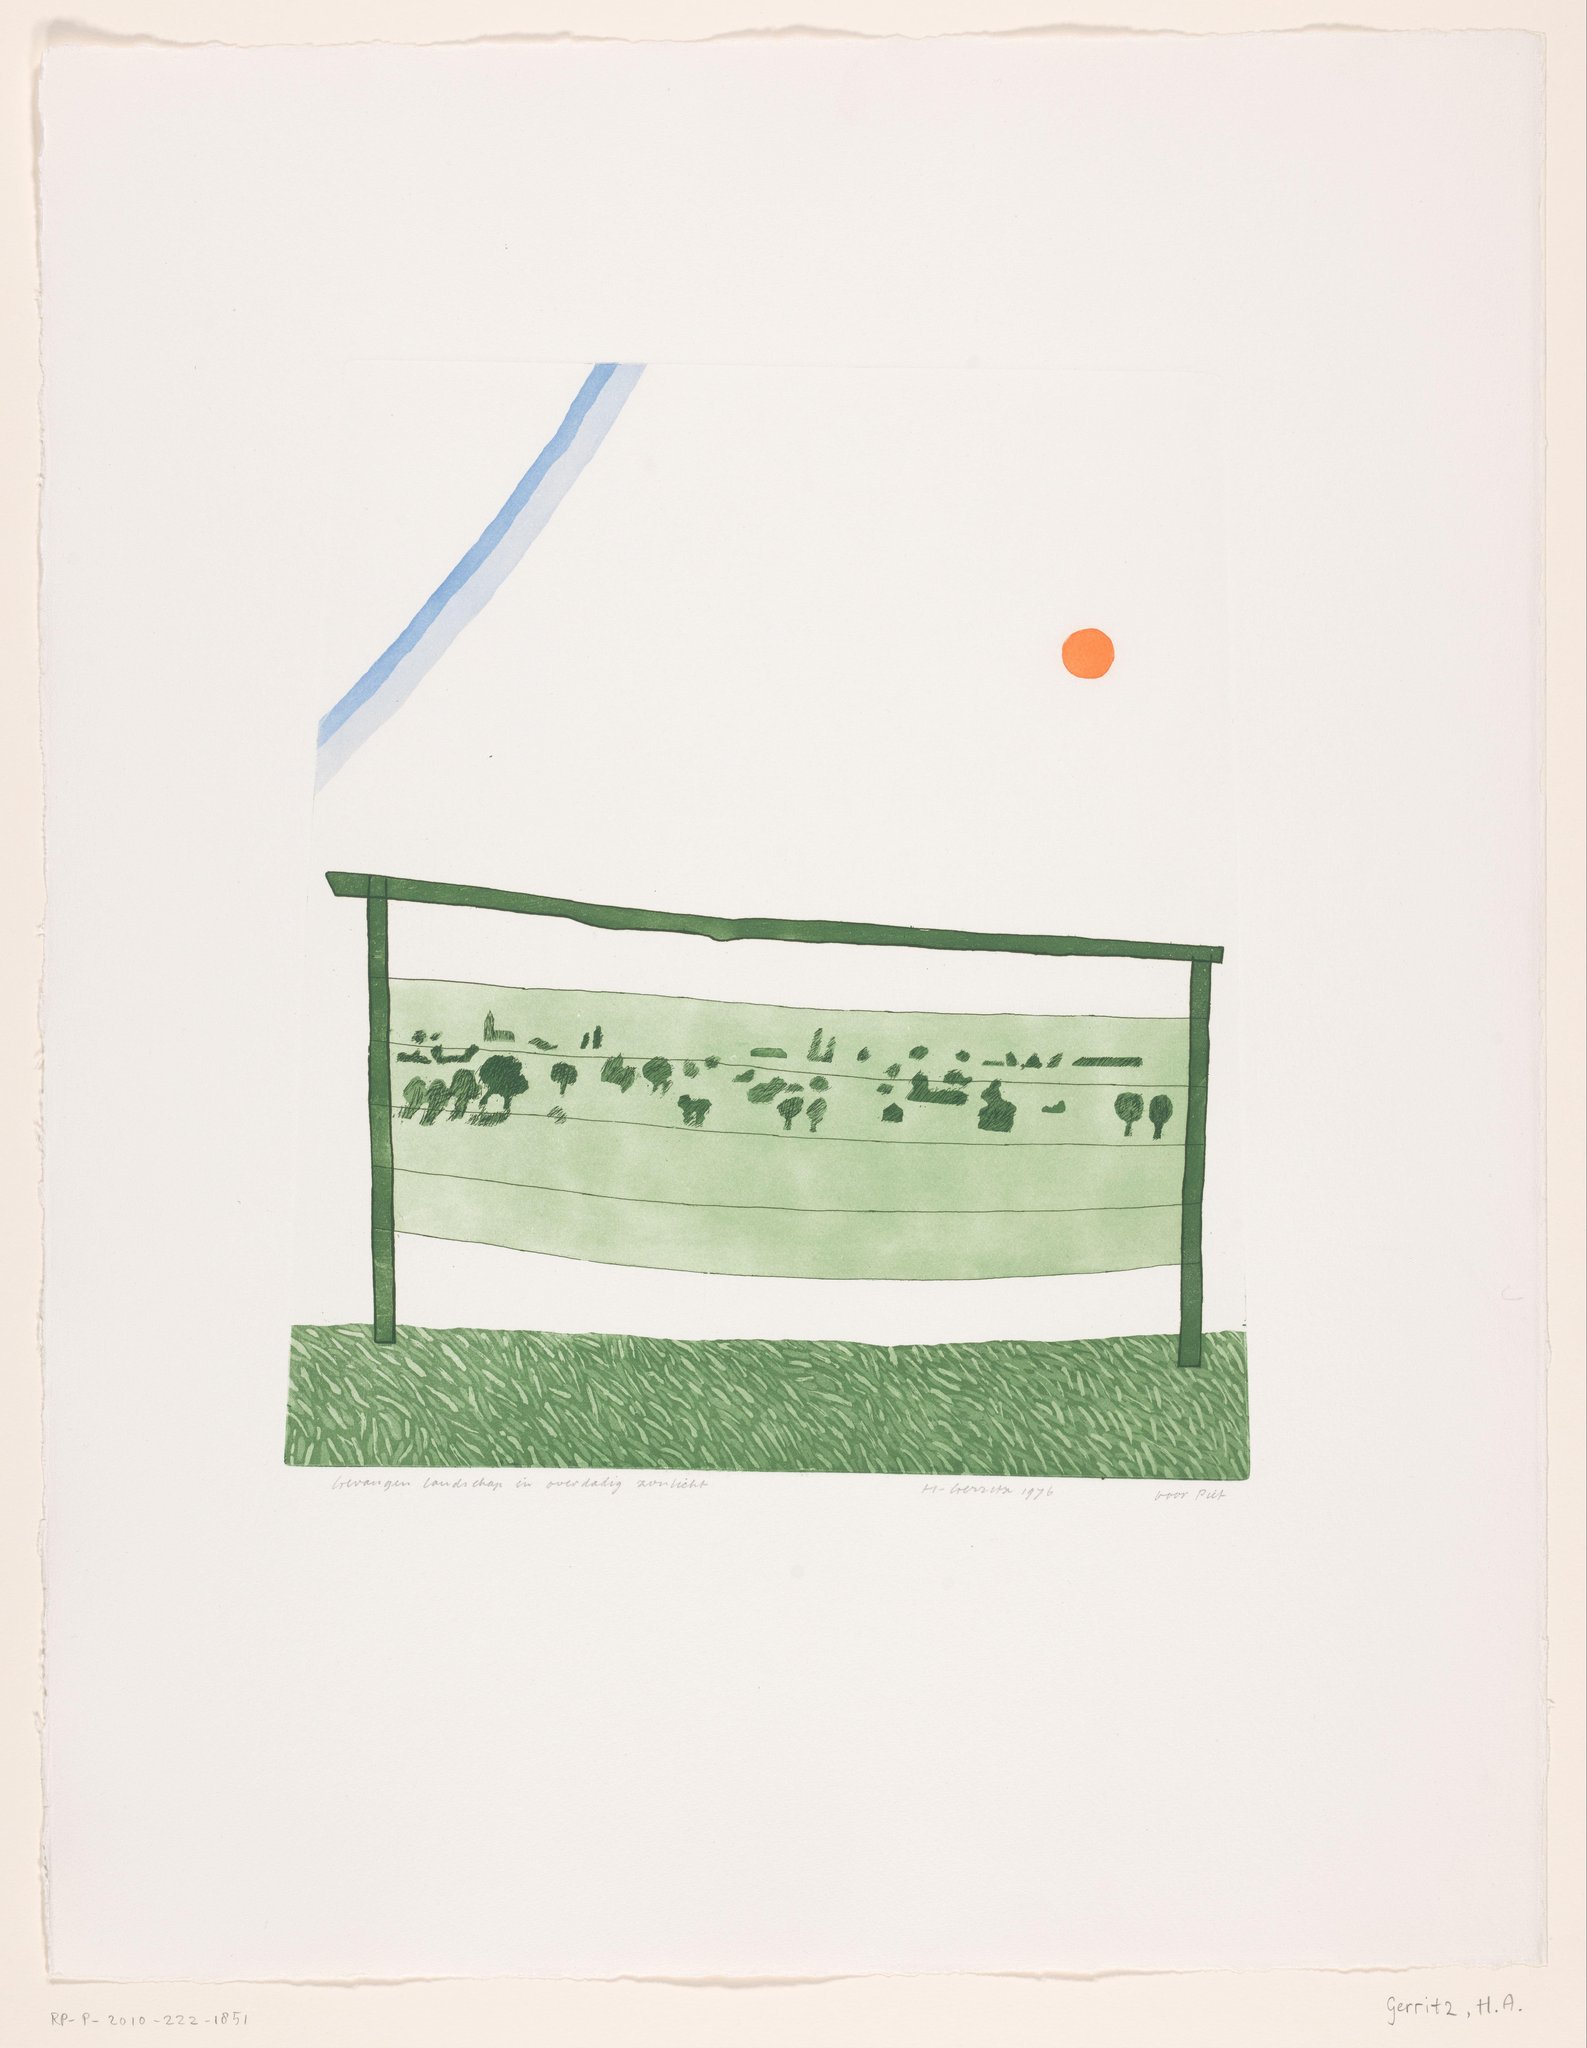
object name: print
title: Gevangen landschap in overdadig zonlicht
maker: harrie a. gerritz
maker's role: draughtsman, painter, print maker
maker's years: 1940-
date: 1976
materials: paper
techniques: aquatint, intaglio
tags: landscapes in the temperate zone, receiver, fence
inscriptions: dedication: ‘voor Piet’, inscription: ‘PC’, collector's mark: Lugt 2228